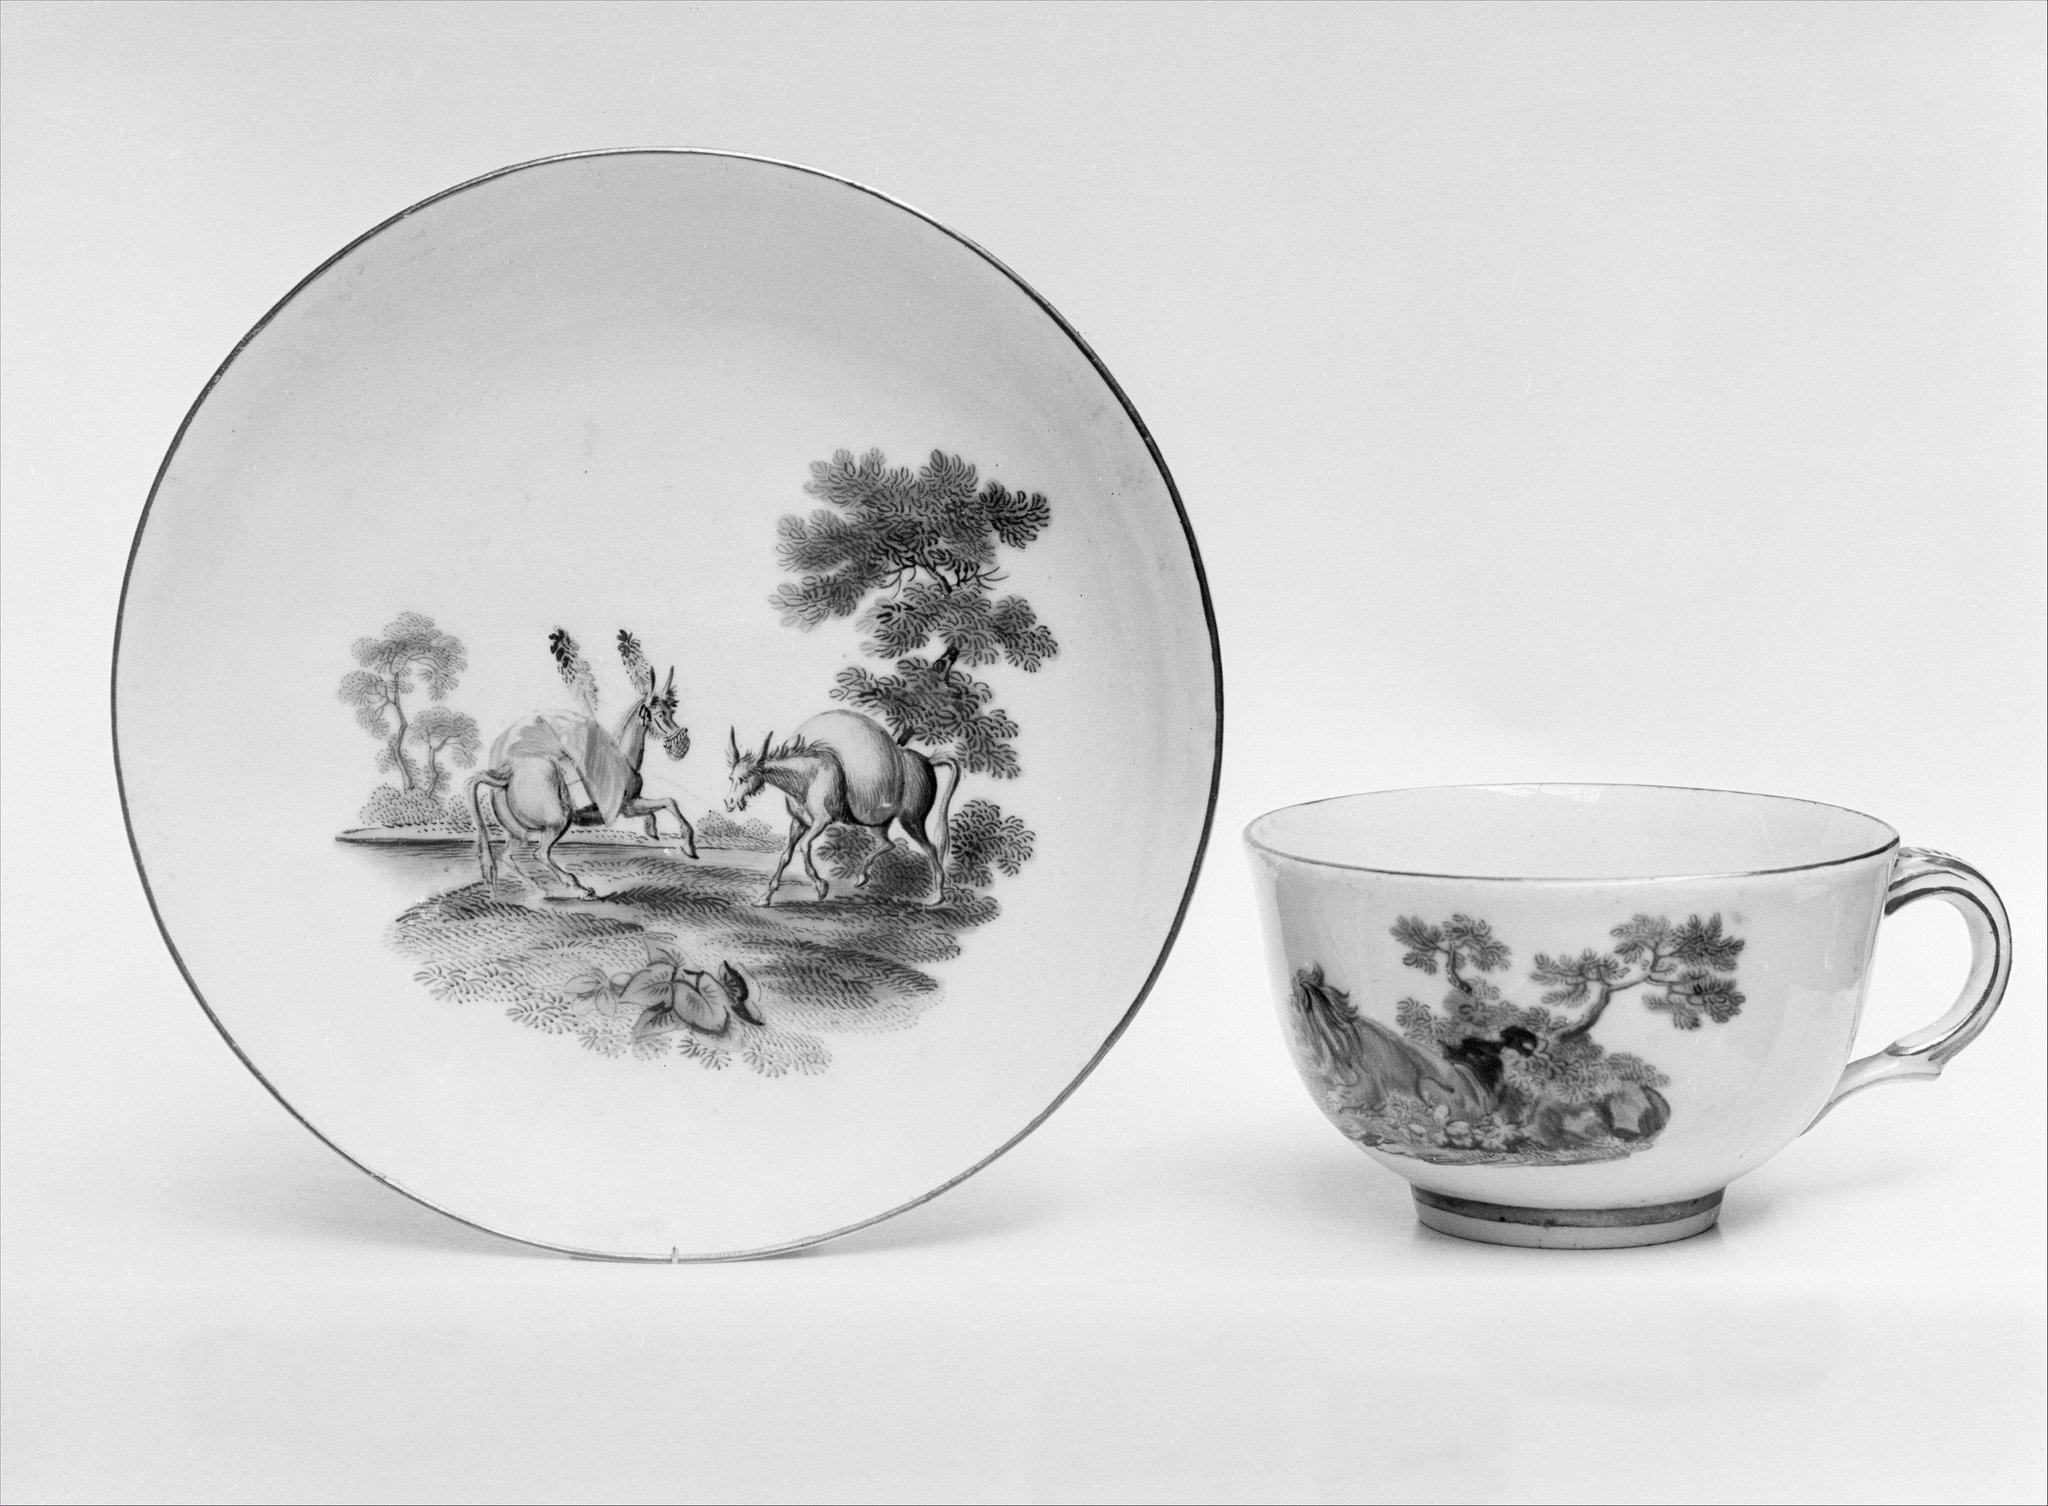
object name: saucer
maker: tournai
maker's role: factory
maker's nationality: belgian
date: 1763-1771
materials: soft paste porcelain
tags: donkeys,trees